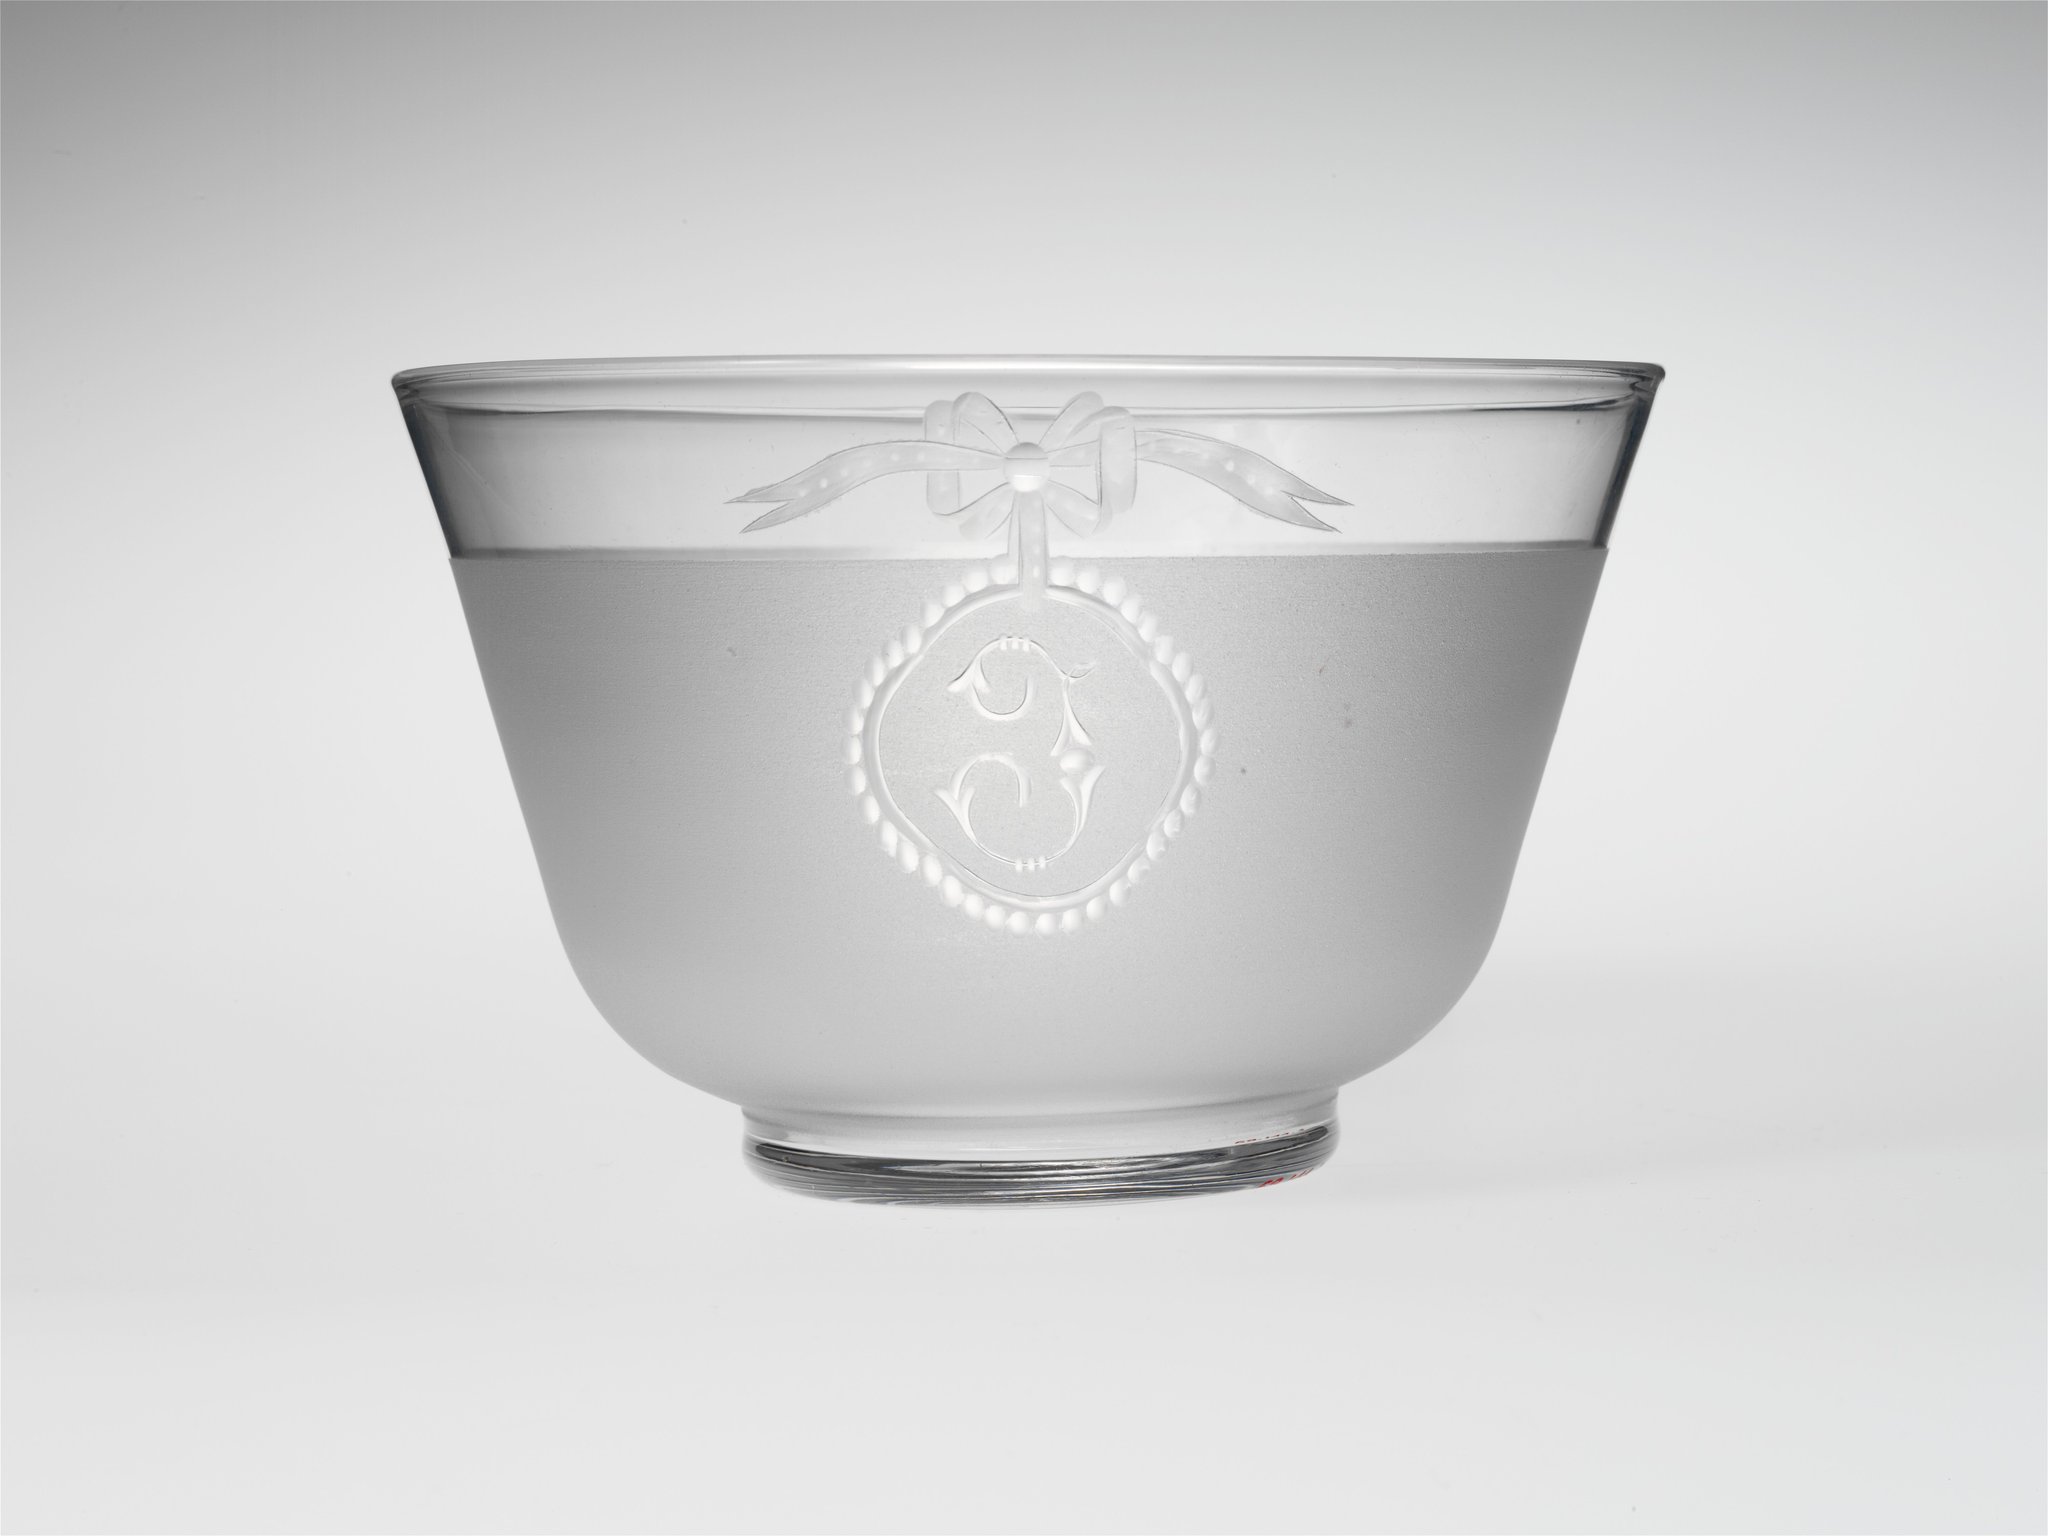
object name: finger bowl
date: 1830-1870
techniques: glassblowing